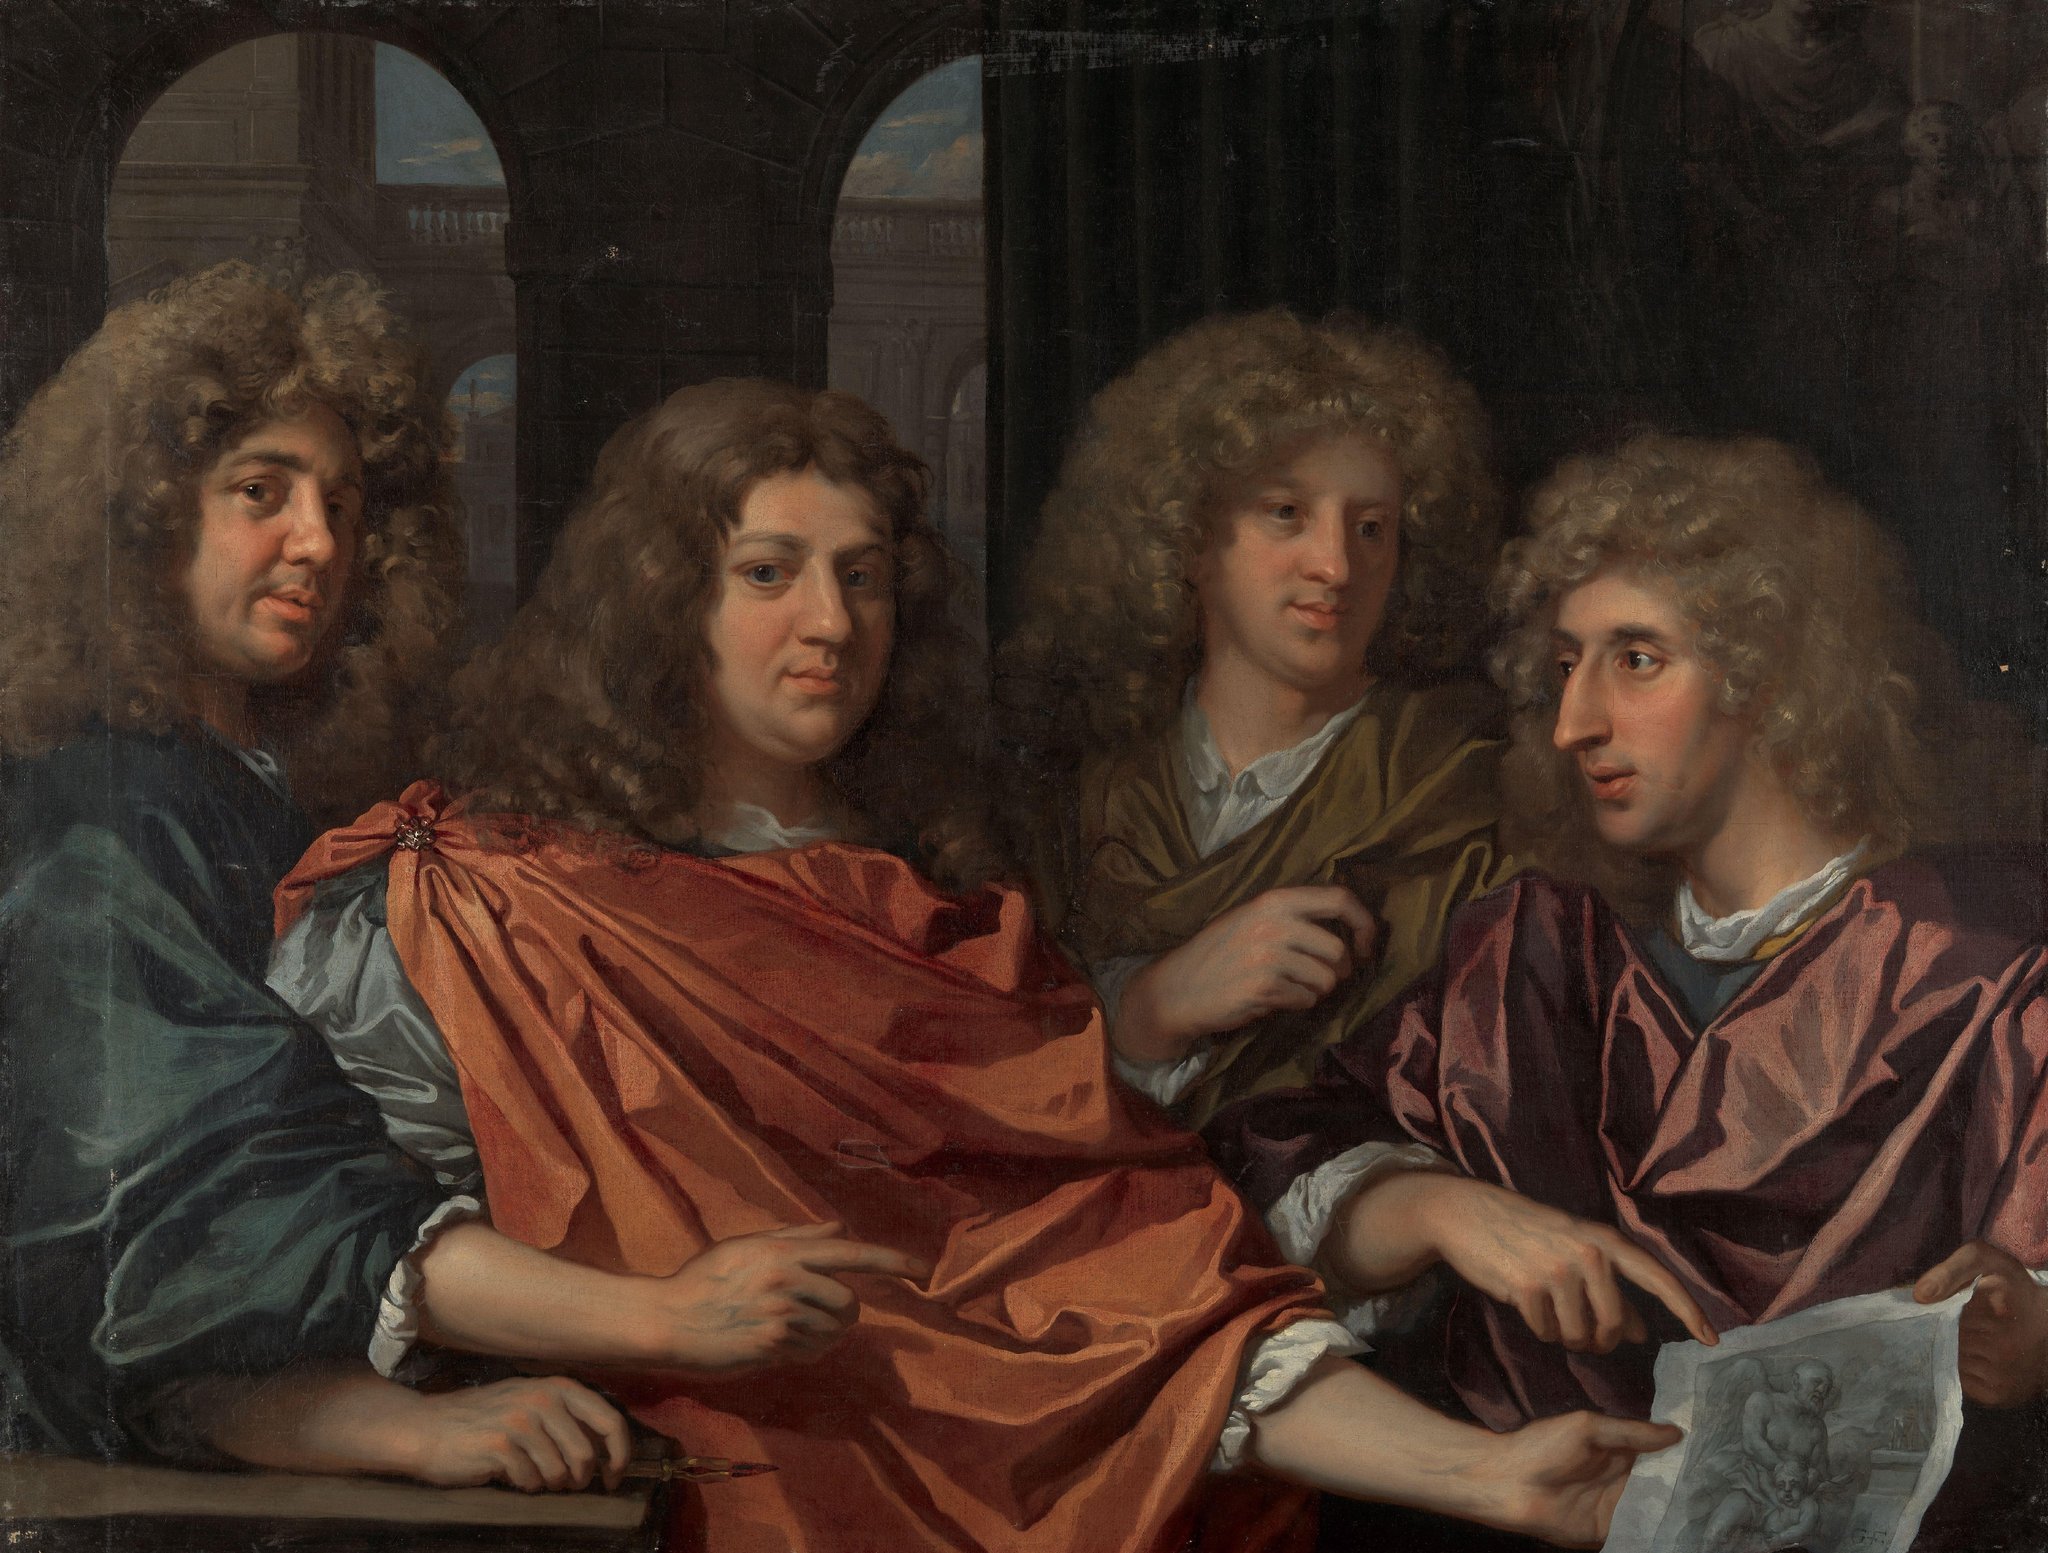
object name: painting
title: Groepsportret van vier kunstenaars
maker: monogrammist gf (schilder)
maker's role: painter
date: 1680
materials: canvas, oil, paint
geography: london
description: Het groepsportret toont de borstbeelden van vier mannen met lang haar (pruiken) die zijn gehuld in antieke toga's. De man geheel rechts houdt een tekening vast waarop Chronos als personificatie van de tijd is afgebeeld die de vleugels van Cupido kortwiekt. Op de rechterachtergrond van de tekening, die met de letters G.F. is gesigneerd, is een pilaar met zandloper afgebeeld als teken van vergankelijkheid. De tekening wordt mede vastgehouden door de tweede persoon van links, met de rode mantel, die in zijn andere hand een krijthouder vasthoudt. De geportretteerden zijn gesitueerd in een binnenruimte met links op de achtergrond een arcade met klassieke architectuur en met rechts een reliëf in medaillonvorm, waarop een jongen is te zien die wordt geflankeerd door twee volwassen personen in klassieke kledij.